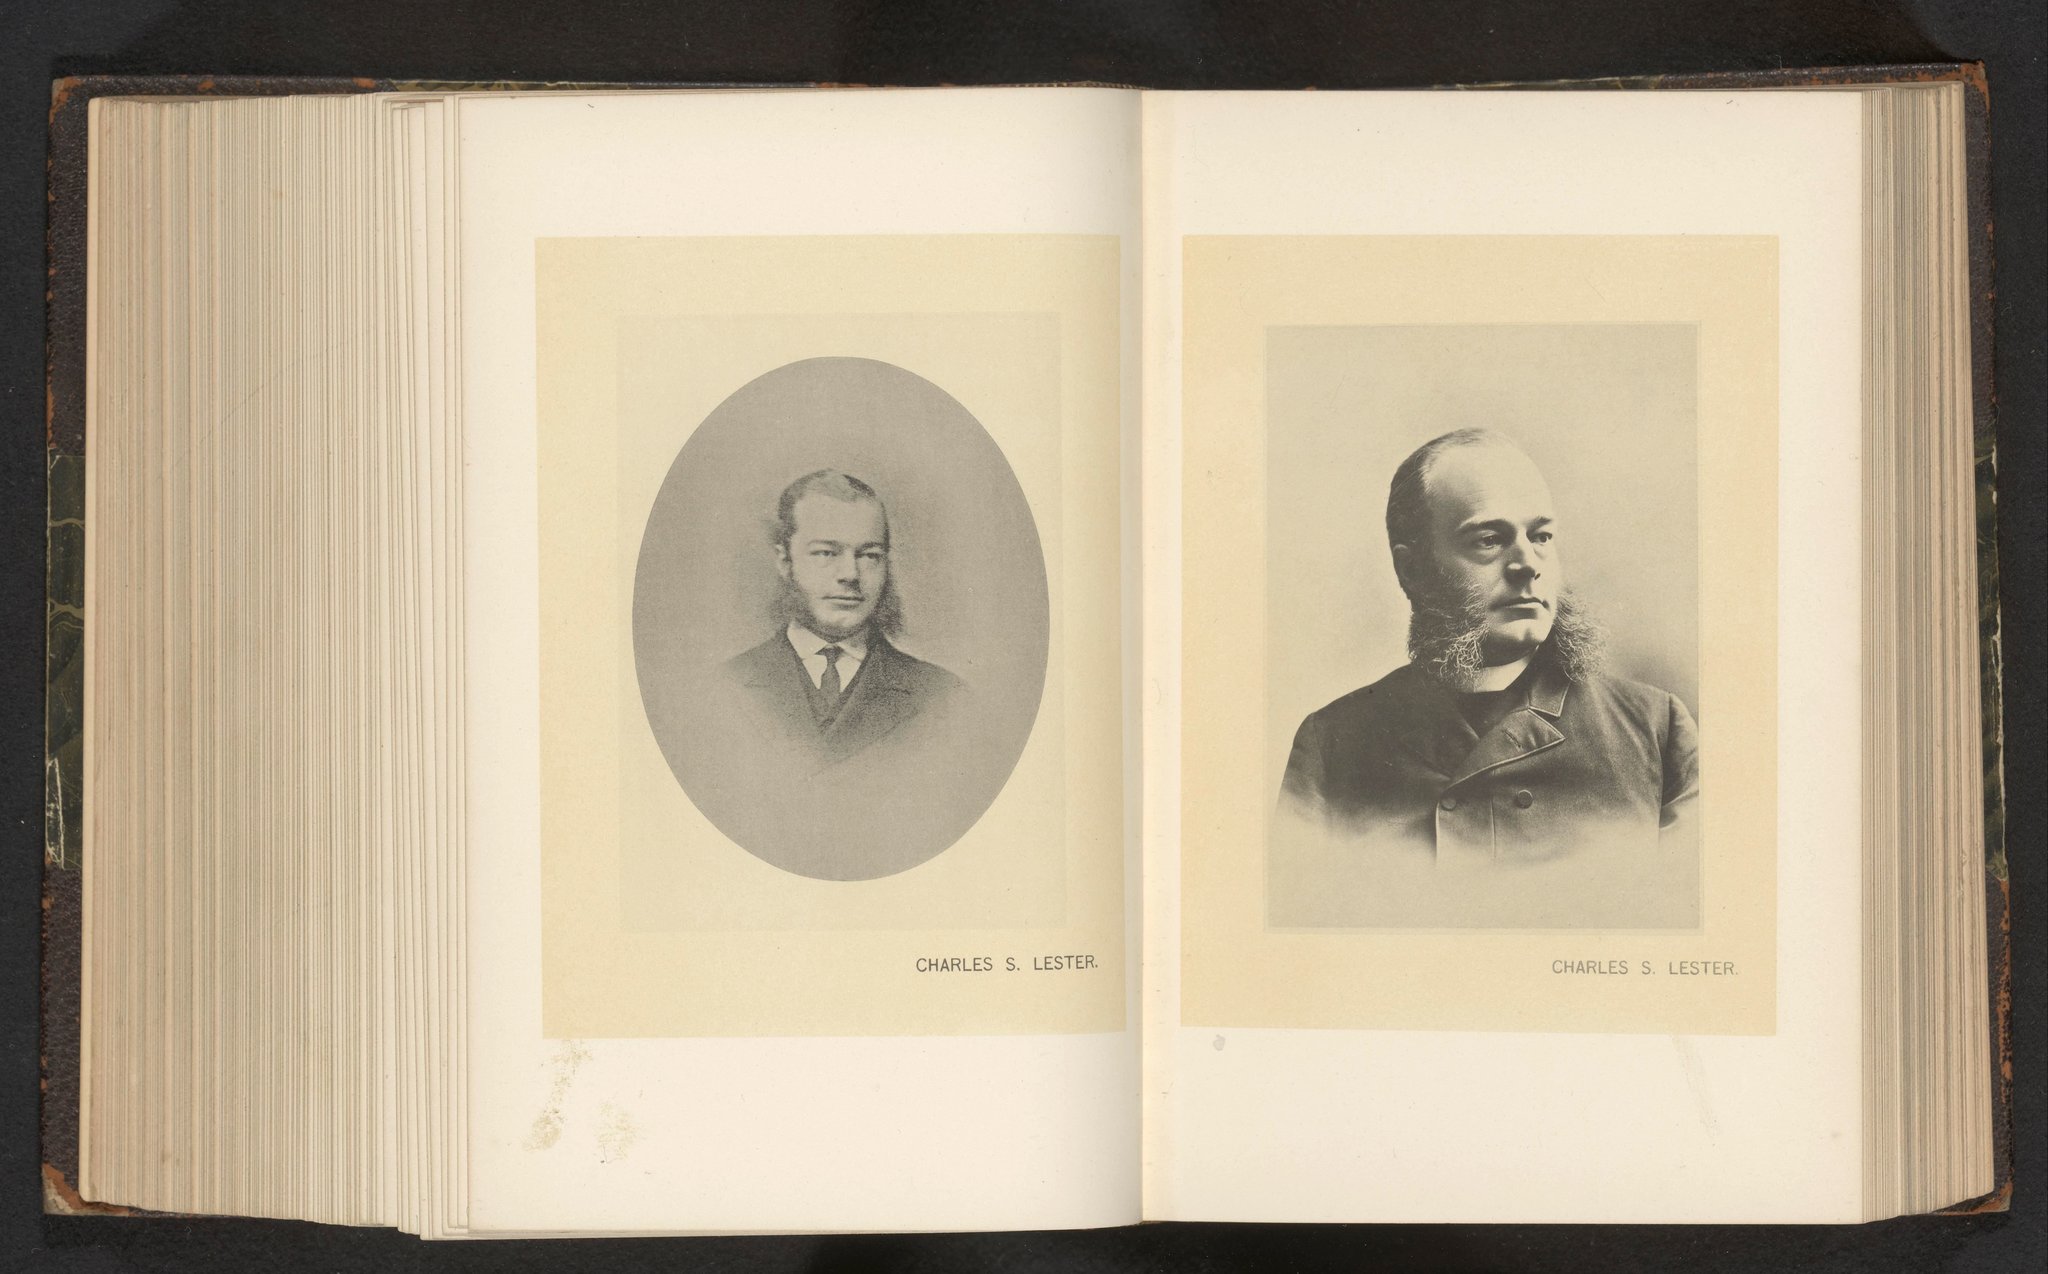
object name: photomechanical print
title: Charles S. Lester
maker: Anonymous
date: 1889-1894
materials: paper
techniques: photoaquatint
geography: boston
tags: adult man